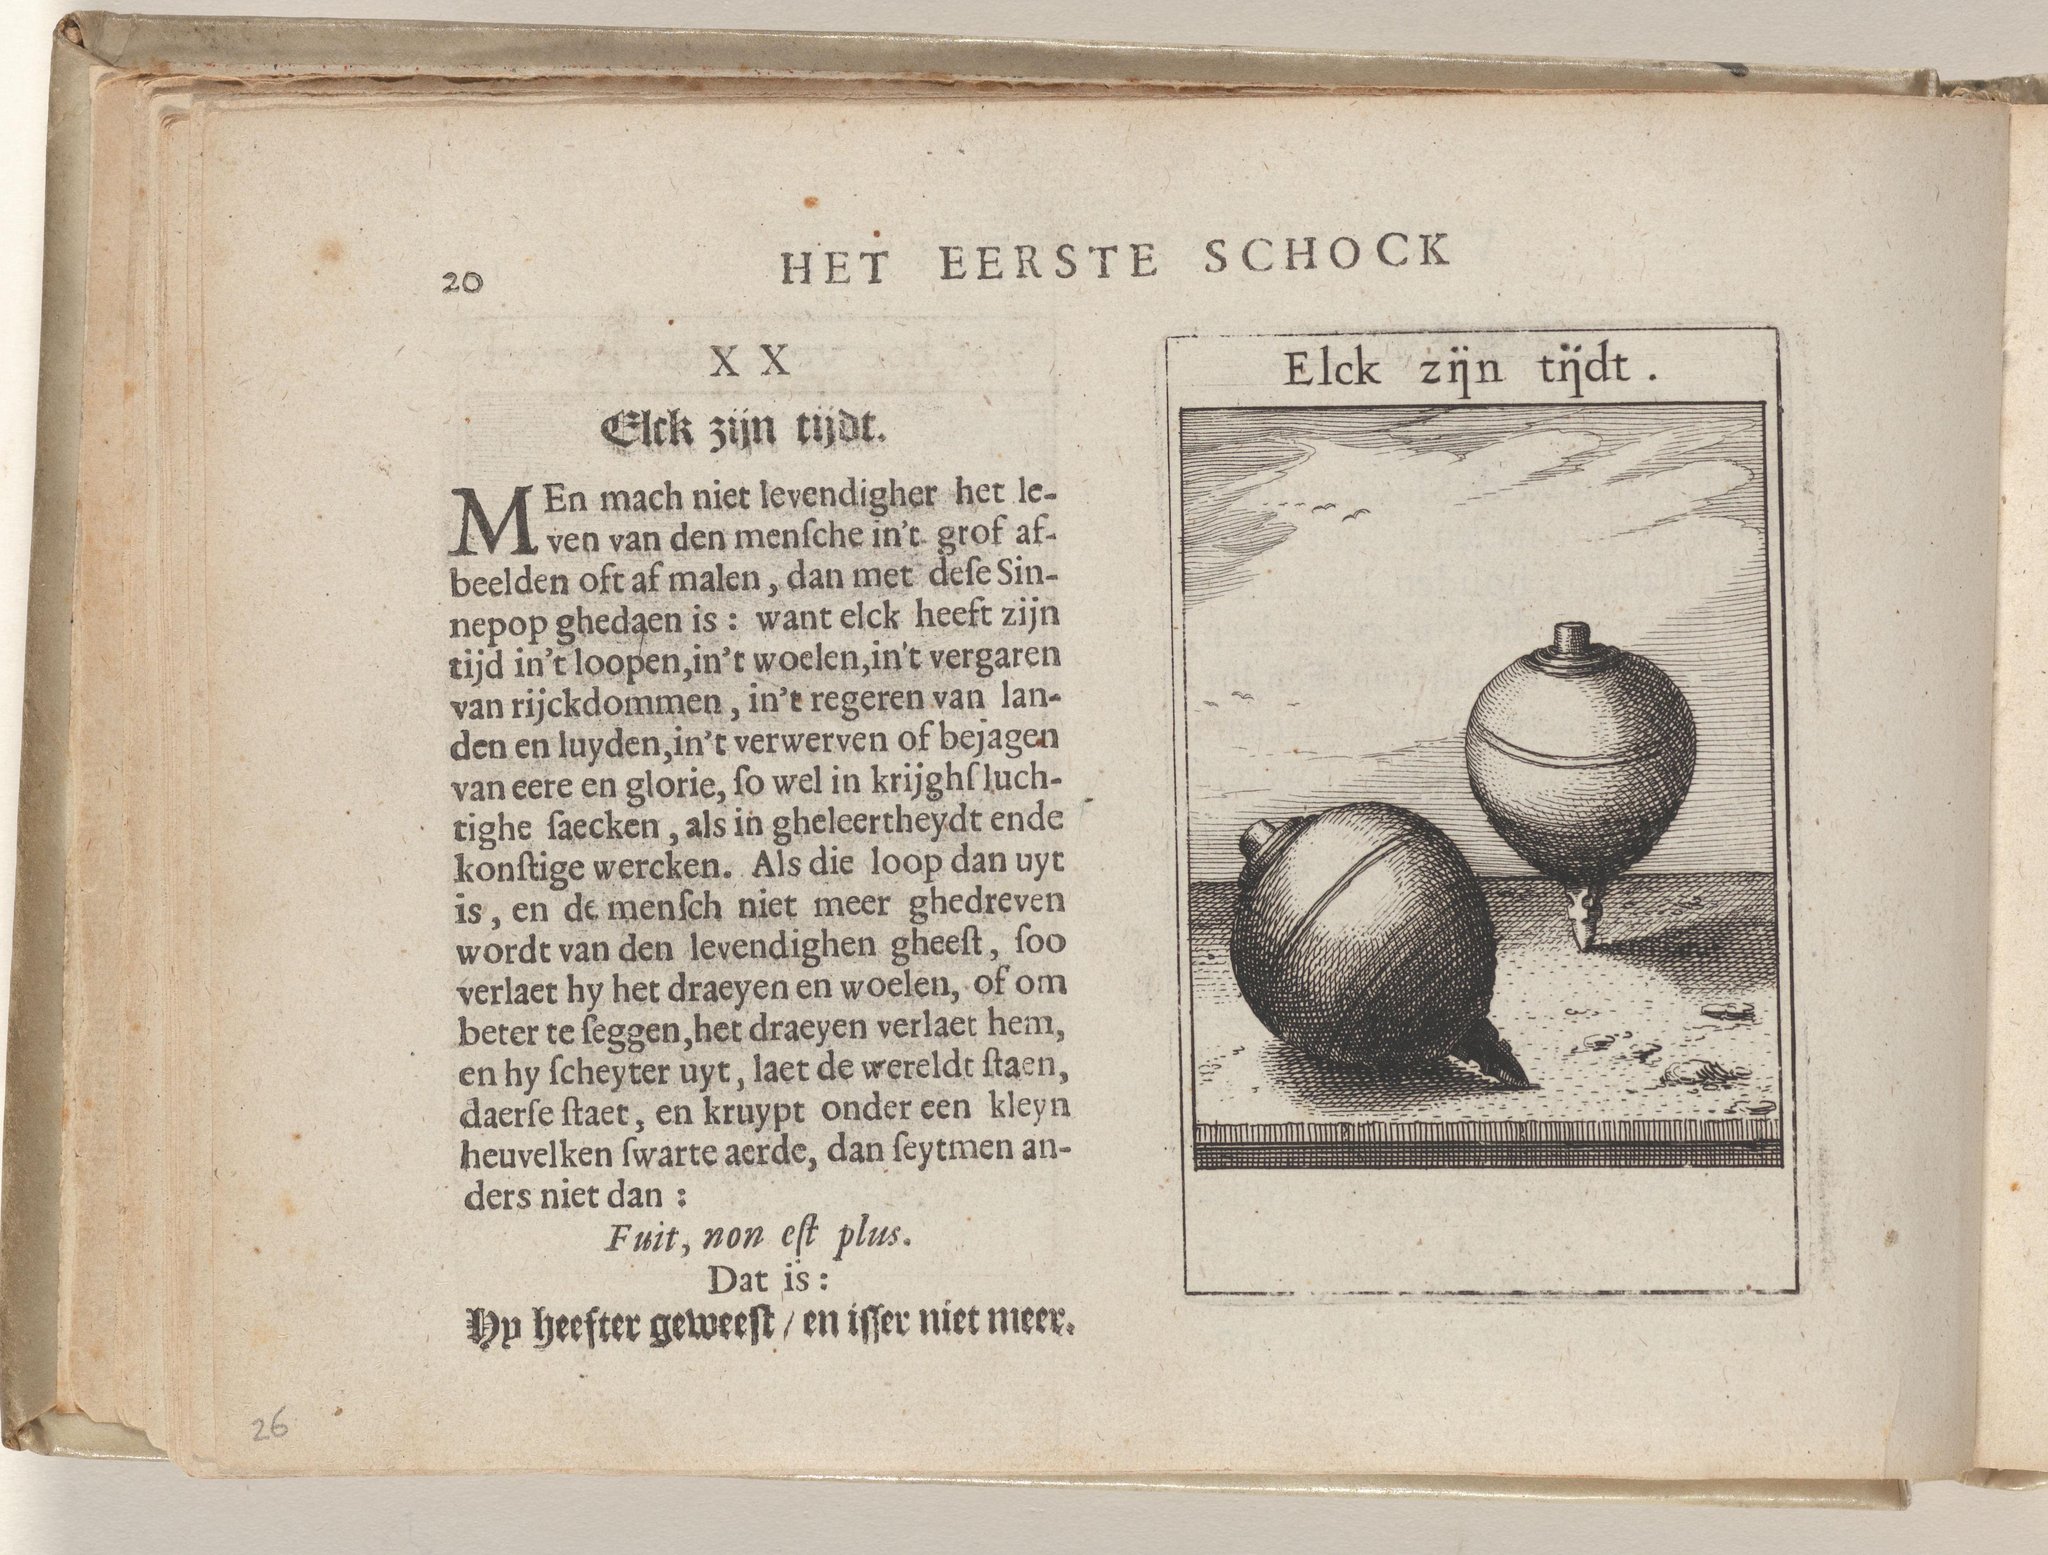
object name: album leaf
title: XX Elck zijn tijdt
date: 1614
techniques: engraving, printing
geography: the hague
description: XX Elck zijn tijdt. Eerste schok. Onderdeel van 'Sinnepoppen', R. Visscher, 1614.